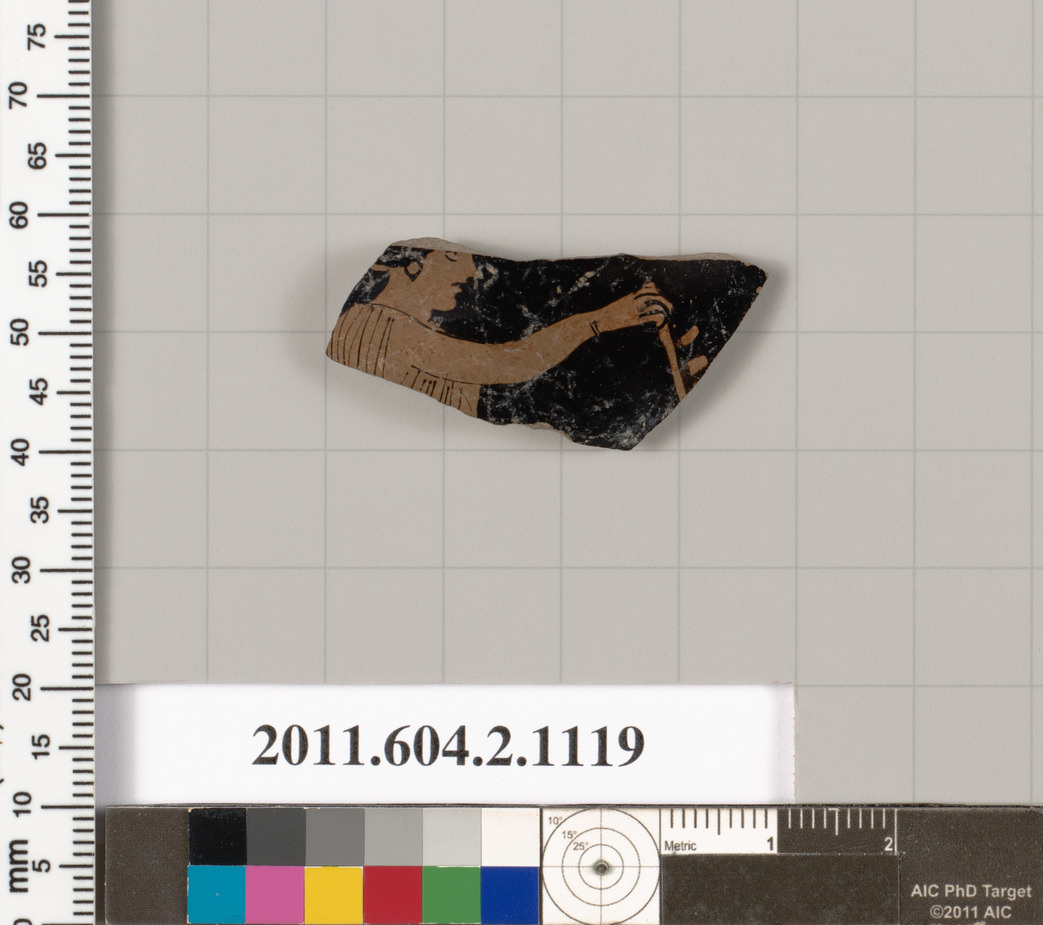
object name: lekythos fragment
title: Terracotta fragment of a squat lekythos (oil flask)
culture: greek, attic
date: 460-450 BCE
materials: terracotta